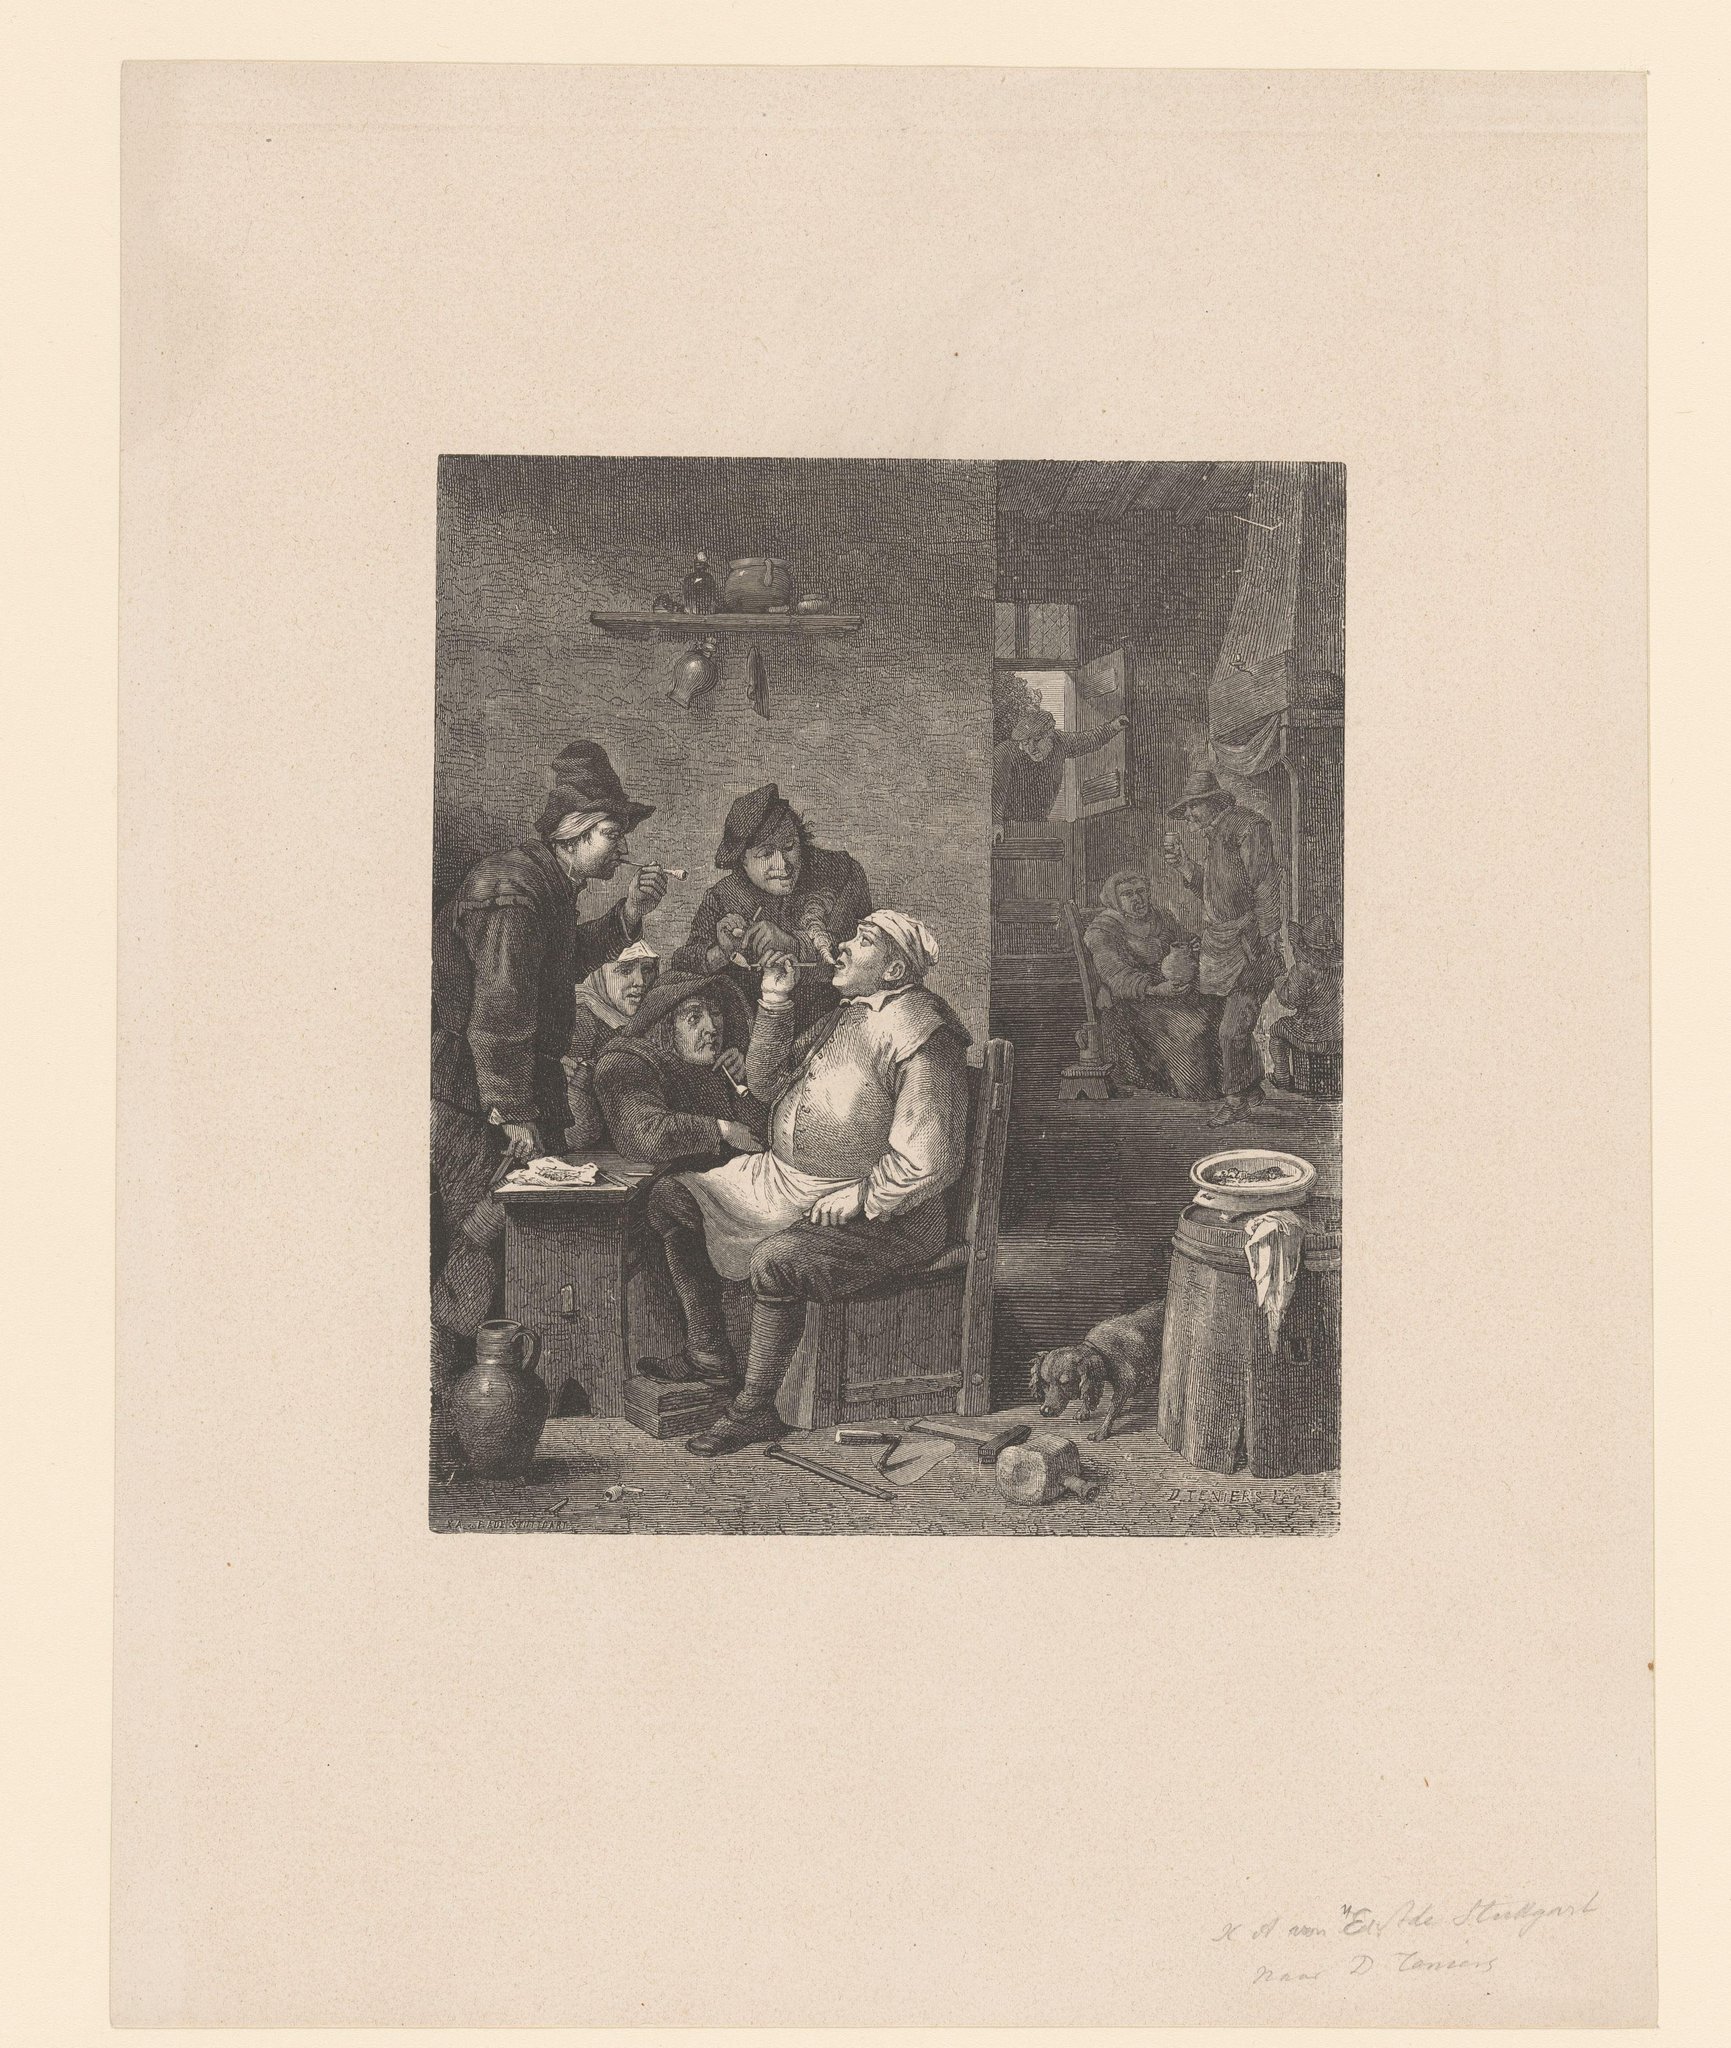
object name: print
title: Mannen roken in een herberg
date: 1800-1900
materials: paper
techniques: engraving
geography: stuttgart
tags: pipe ~ tobacco, hotel, hostelry, inn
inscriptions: tekst, recto rechtsonder, handgeschreven in potlood: naam van de kunstenaars